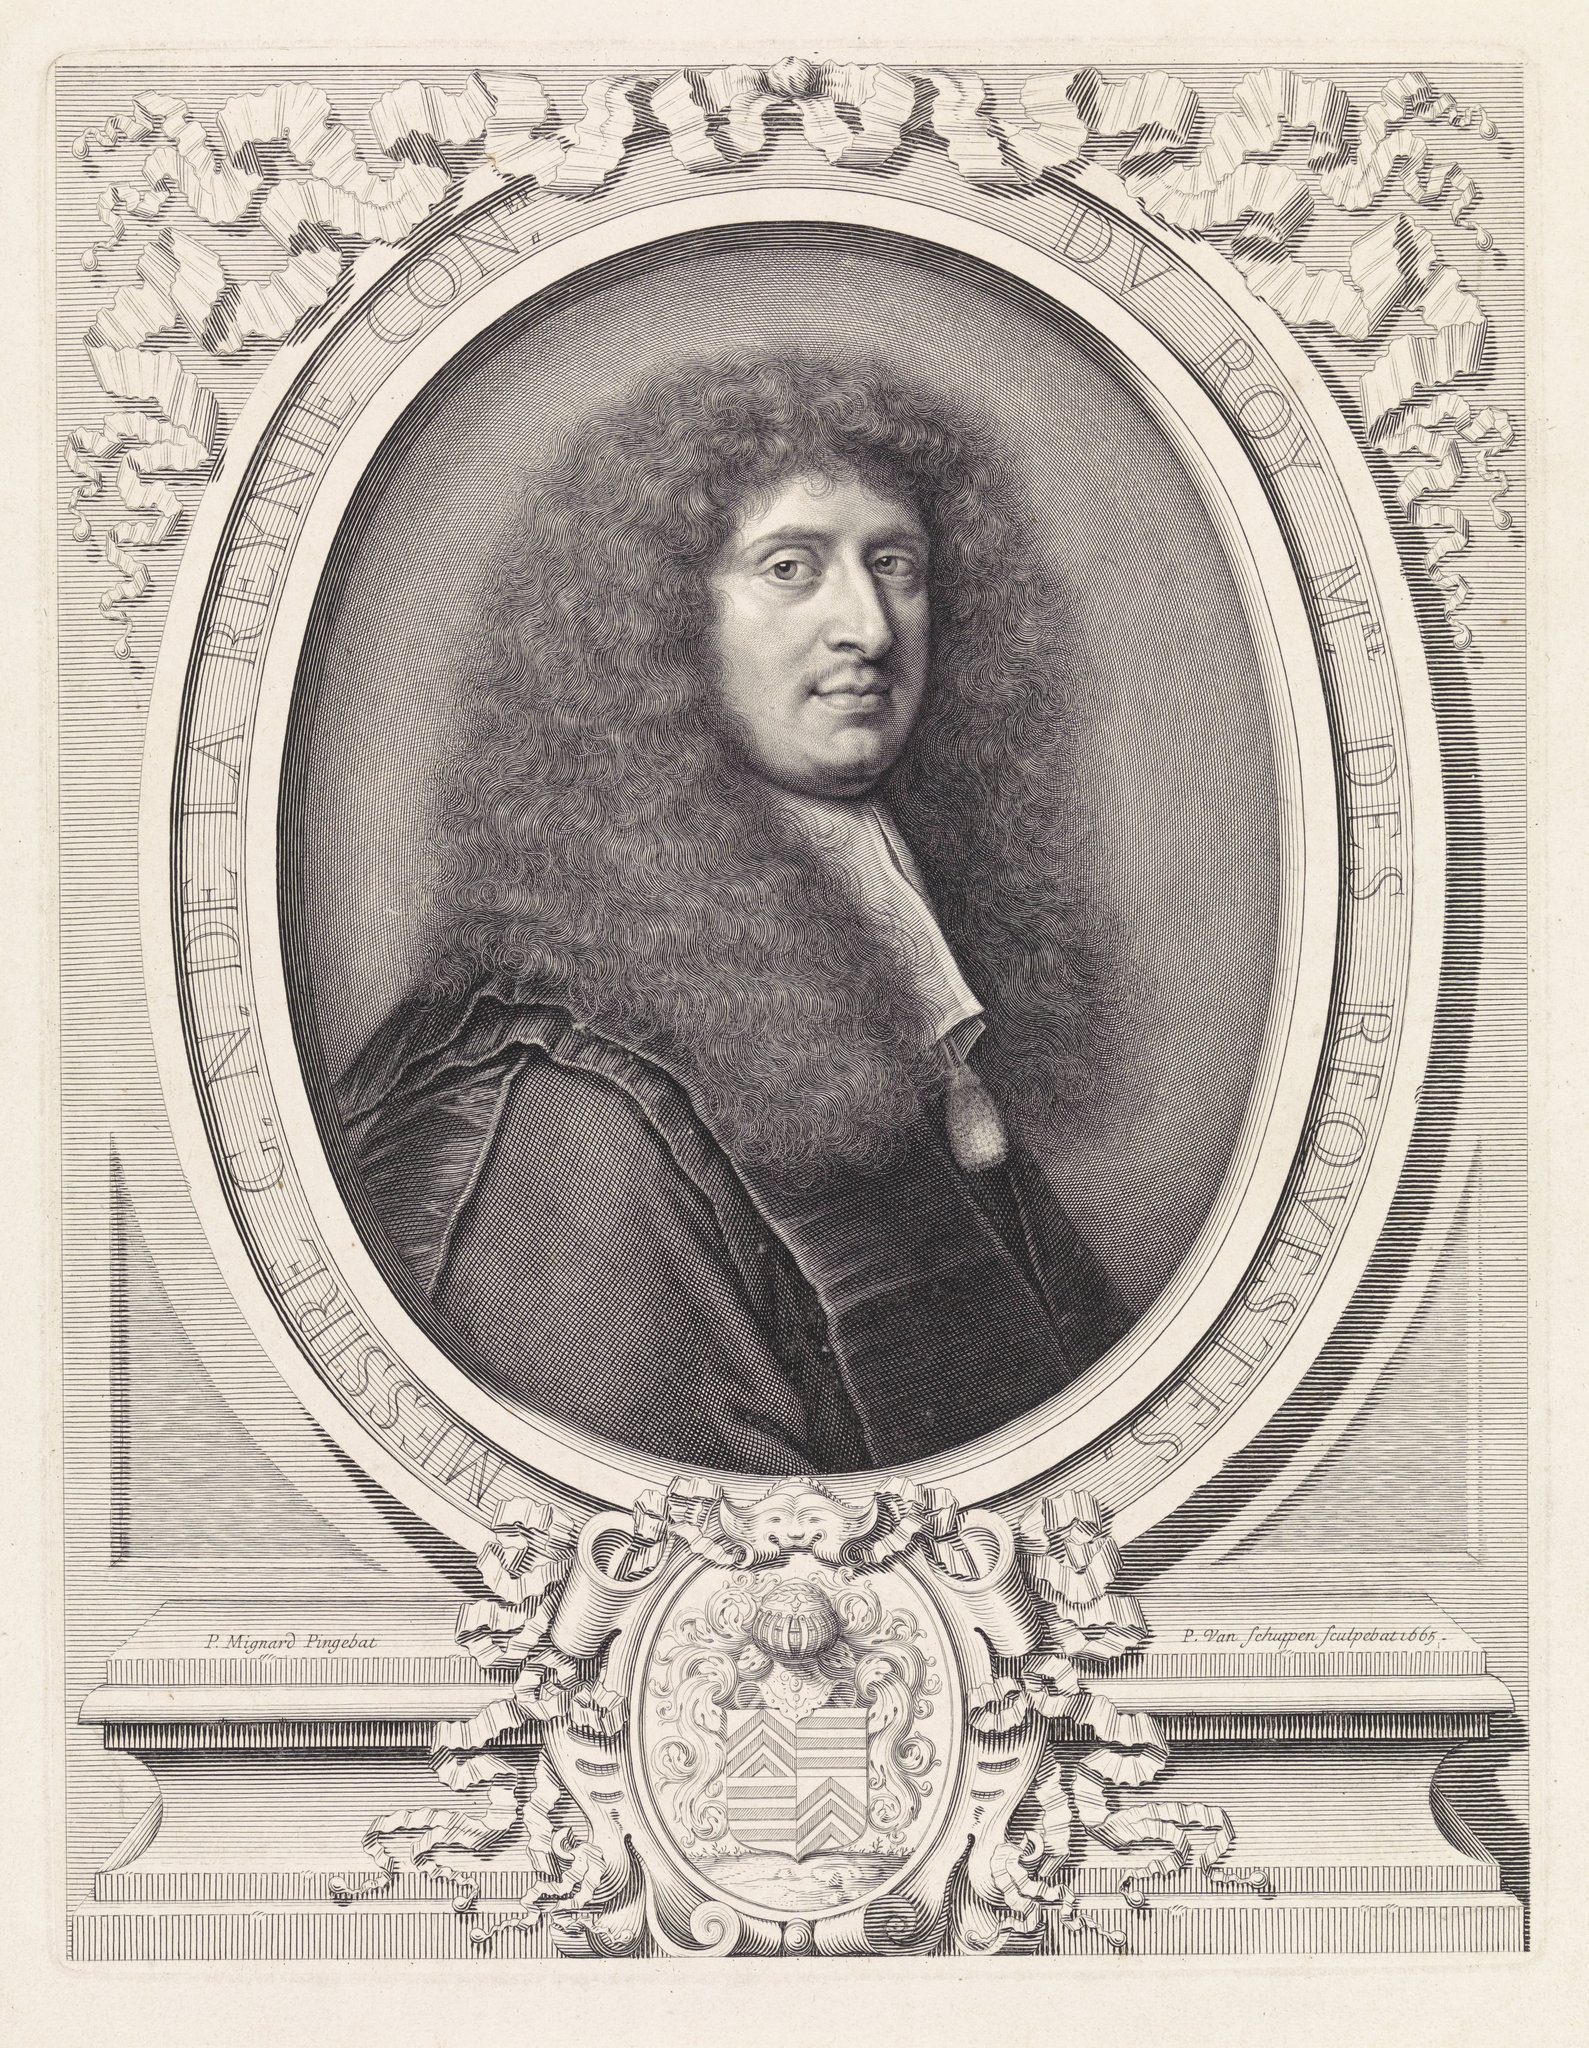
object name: print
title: Portret van Gabriel Nicolas de La Reynie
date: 1601-1665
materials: paper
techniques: engraving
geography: paris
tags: limoges, staatsman, bibliofiel, gabriel nicolas de la reynie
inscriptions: collector's mark: Lugt 240